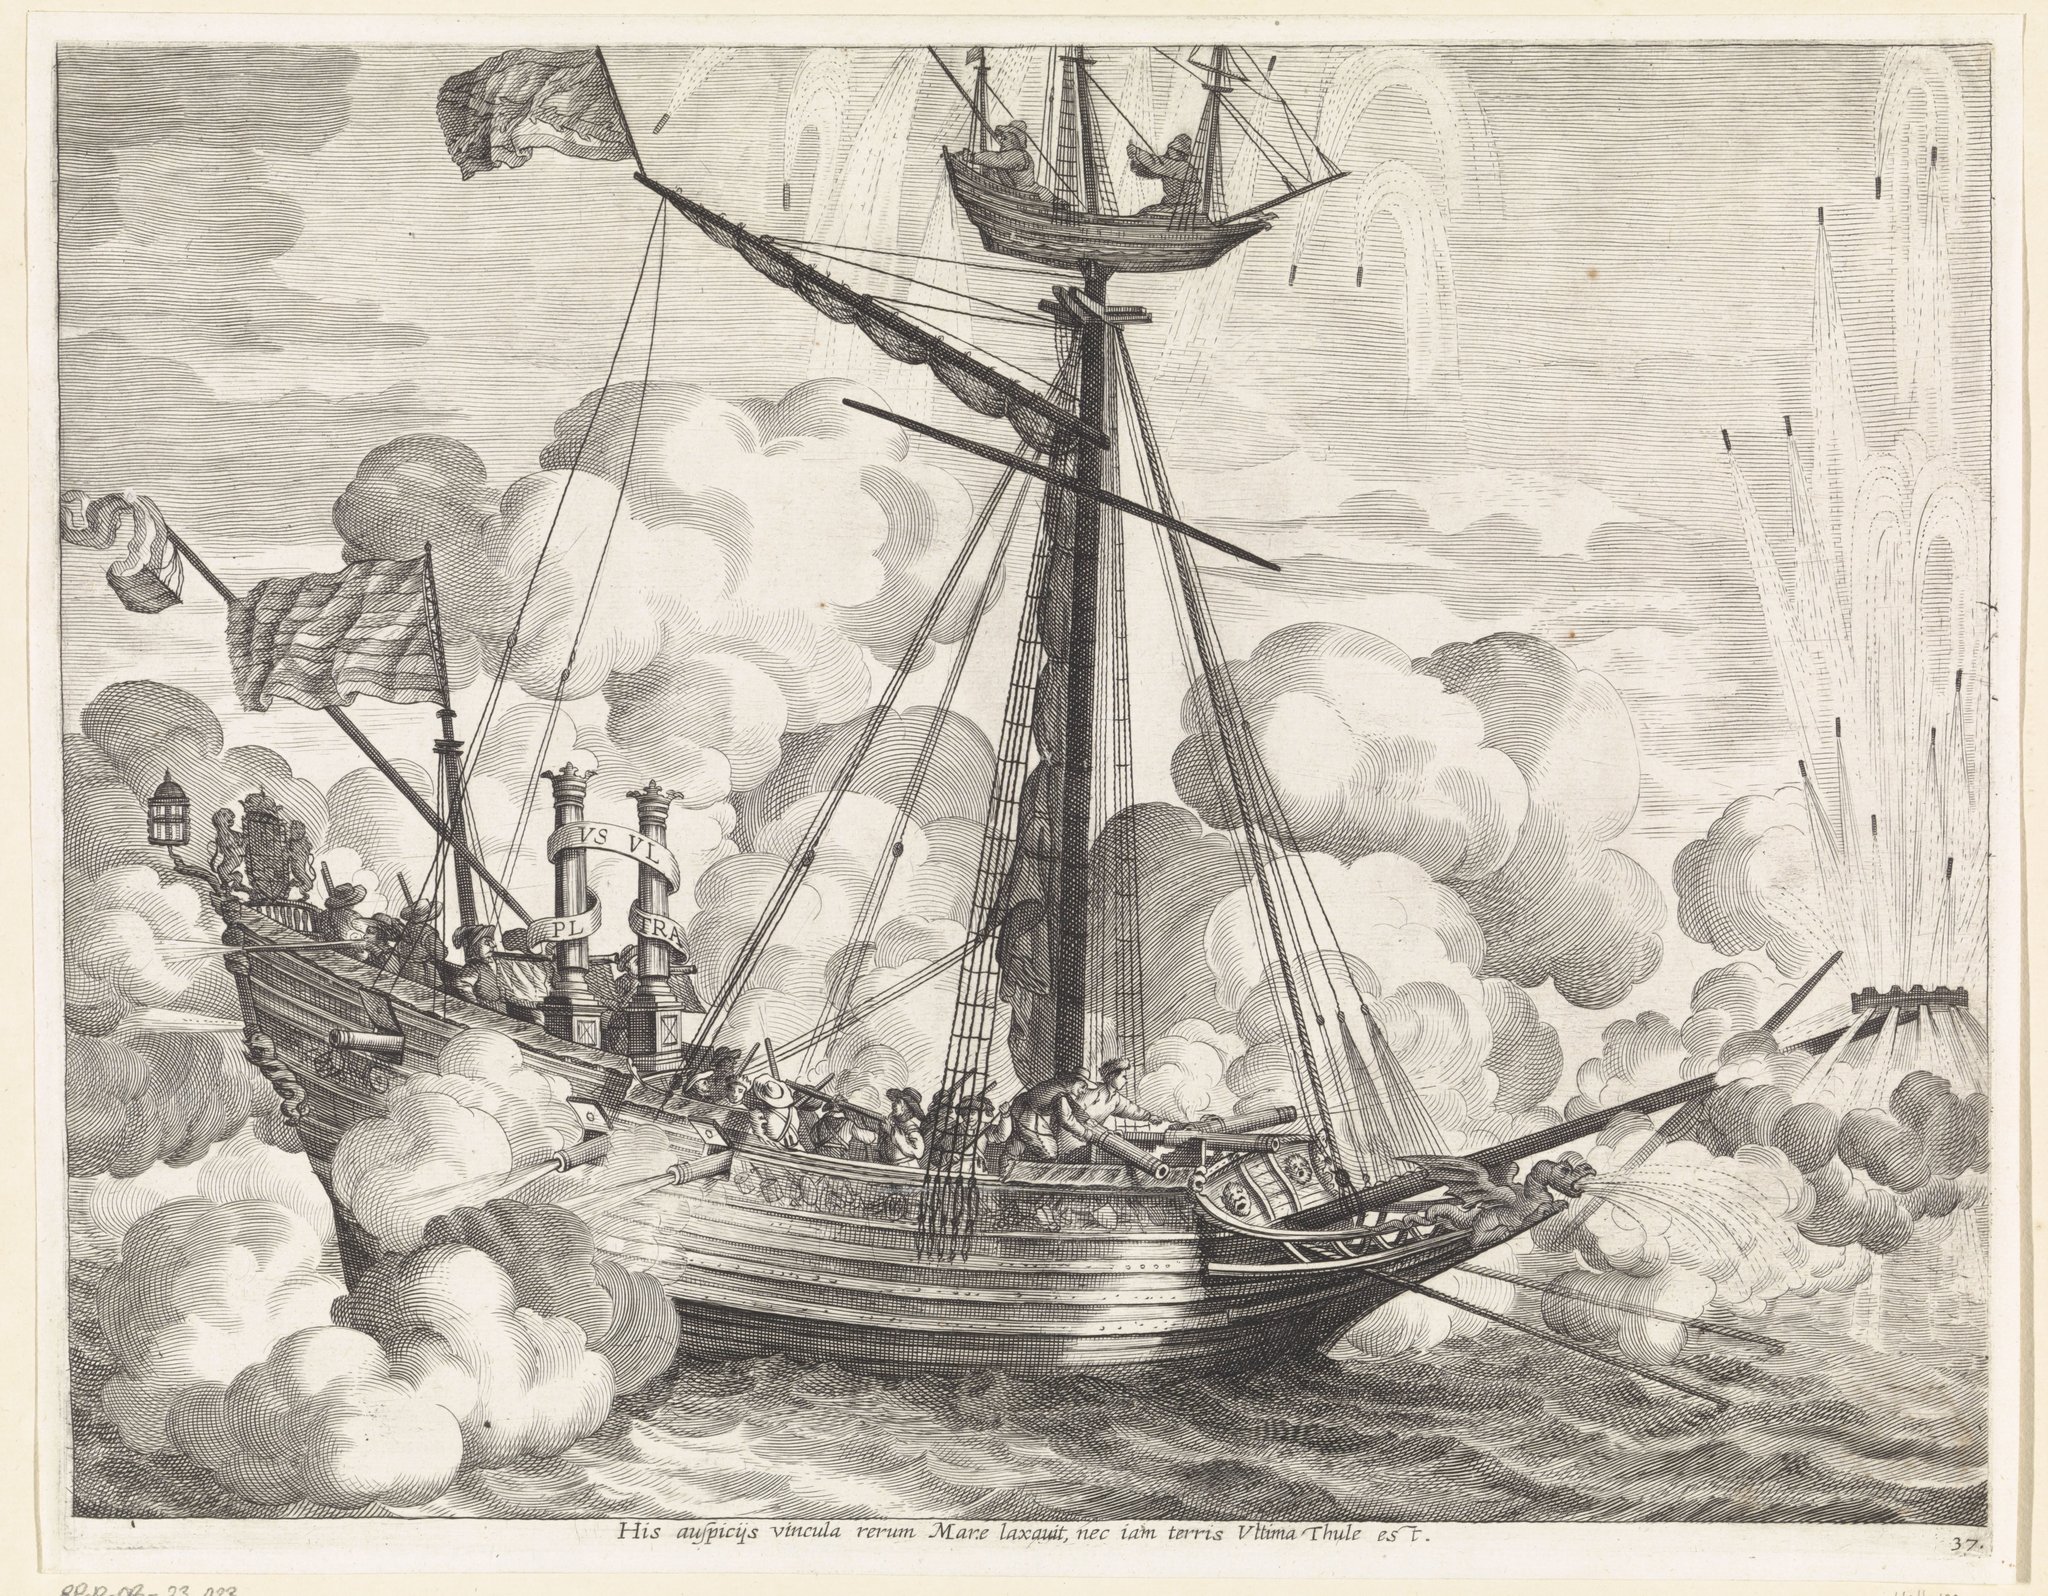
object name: print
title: His auspicijs vincula rerum Mare laxauit, nec iam terris Ultima Thule est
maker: jacob neefs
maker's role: print maker, publisher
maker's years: 1610-1660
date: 1636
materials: paper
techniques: engraving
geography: antwerp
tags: ships (in general) (+ propulsion of vehicle, ship, etc. by wind), triumphal entry and public reception, pageant, 'entrée solennelle', 'joyeuse entrée', bonfire, fire-works - aa - festivities on the water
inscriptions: collector's mark: Lugt 240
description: Spektakel met schip met vuurwerk, vurende kanonnen en de zuilen van Hercules. Prent maakt deel uit van een serie, die de uitgave van de beschrijving van de intocht van de Kardinaal Infant Ferdinand van Oostenrijk te Gent op 28 januari 1635 als de nieuwe landvoogd voor de Spaanse Nederlanden illustreert.